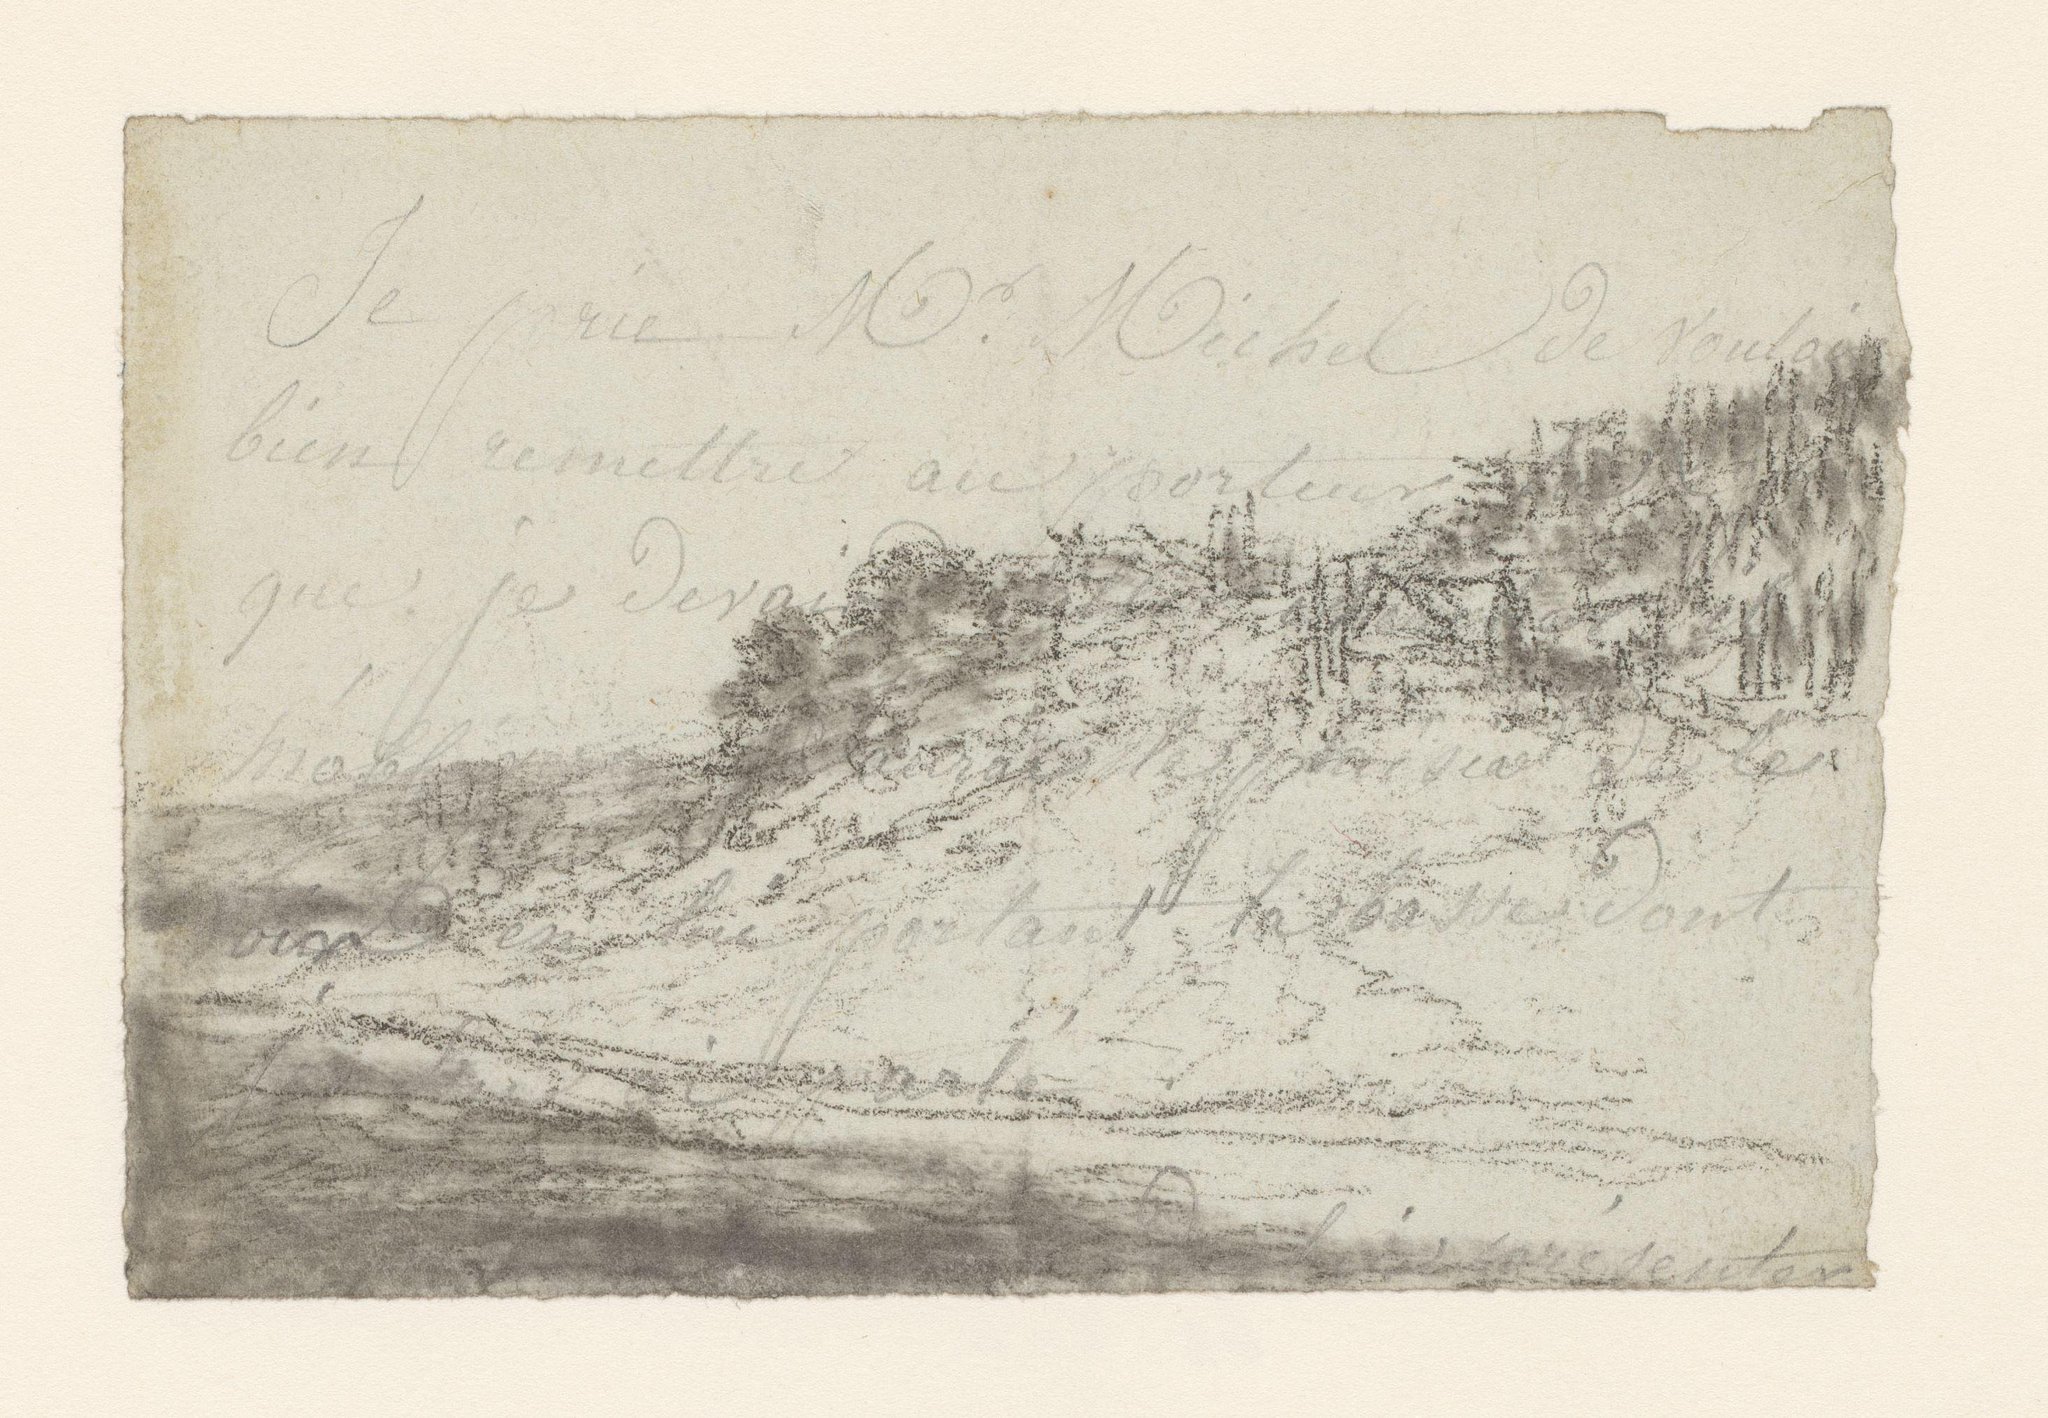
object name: letter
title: Begroeide helling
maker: georges michel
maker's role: draughtsman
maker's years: 1763-1843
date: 1773-1843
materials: chalk, paper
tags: low hill country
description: Een van 120 tekeningen, afkomstig uit een 19e eeuws album met tekeningen van Georges Michel.